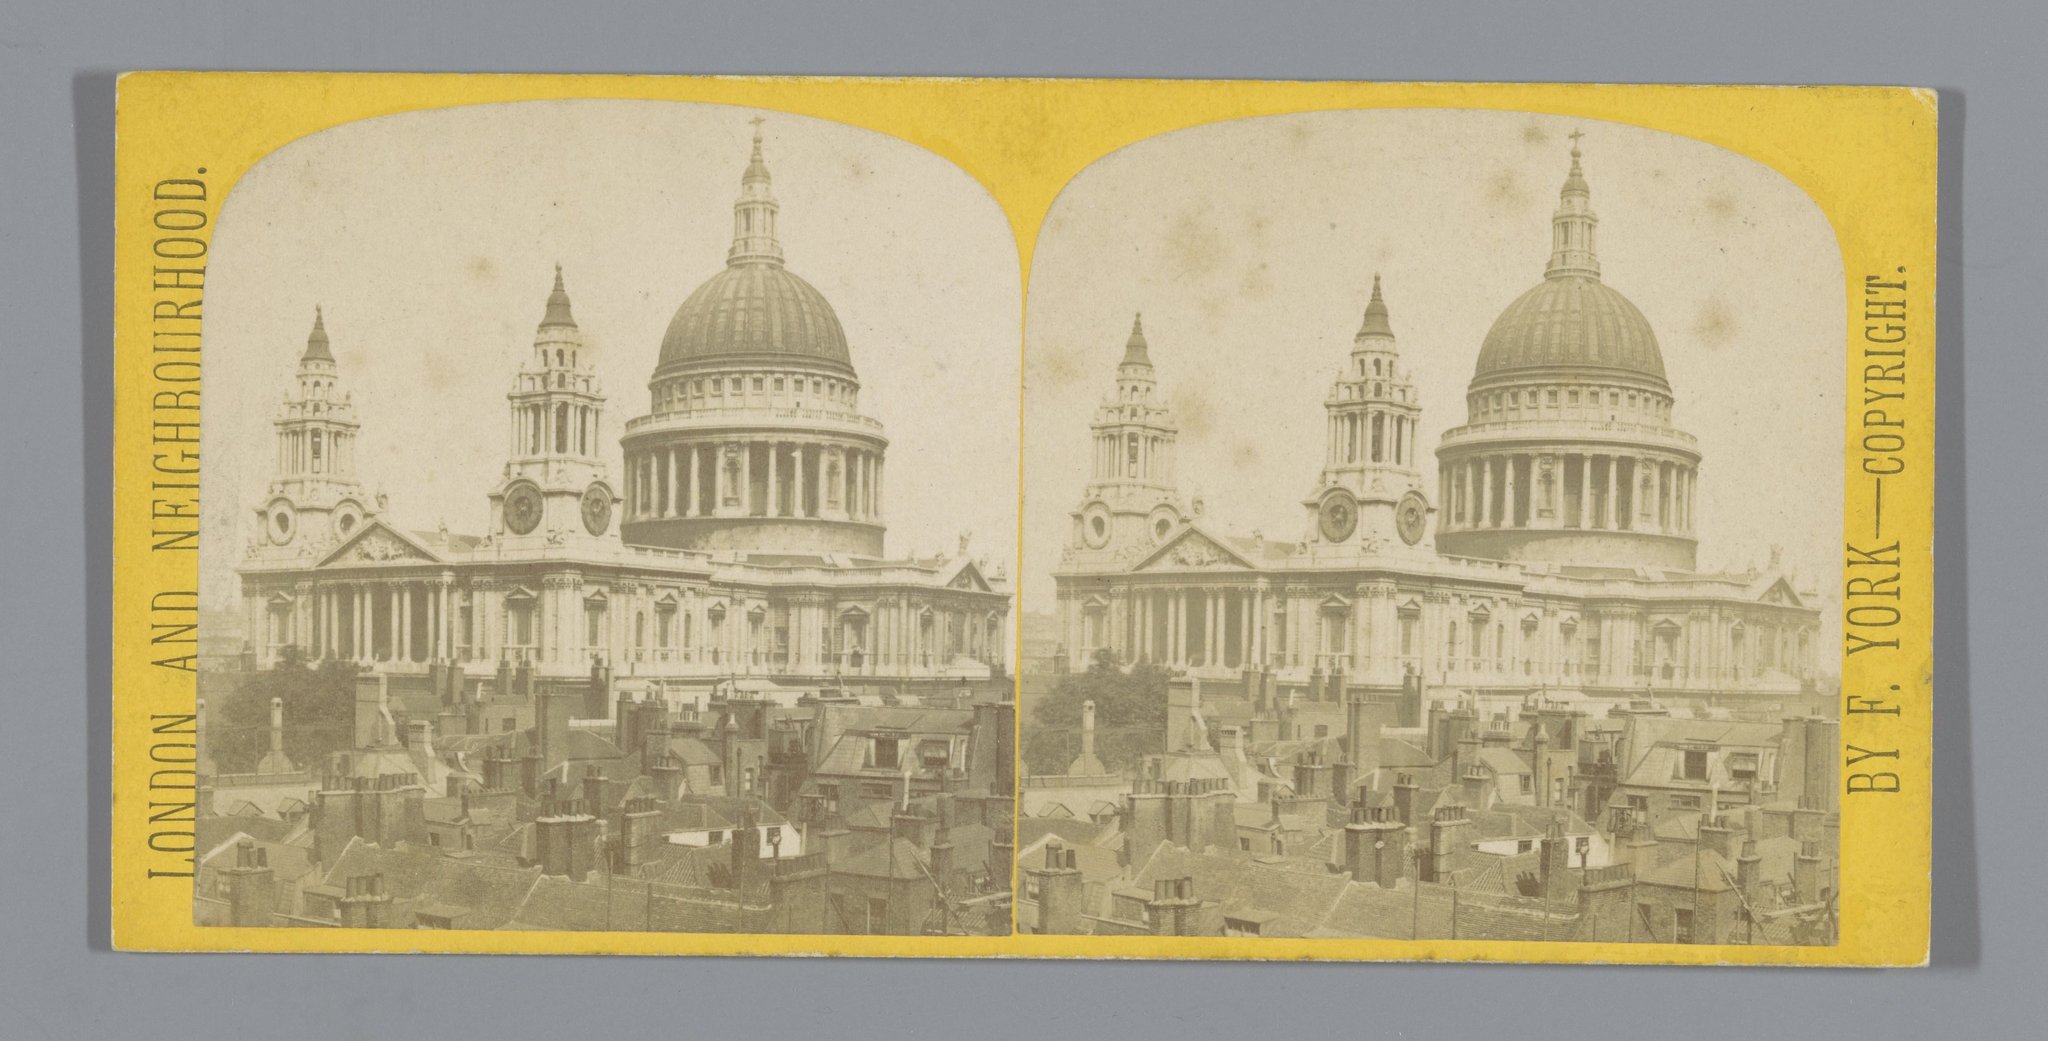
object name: stereograph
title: Gezicht op Saint Paul's Cathedral in Londen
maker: frederick york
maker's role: fotograaf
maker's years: 1823-1903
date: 1860-1880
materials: cardboard, photographic support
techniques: albumen print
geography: london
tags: church (exterior)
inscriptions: number: ‘No. 17.’